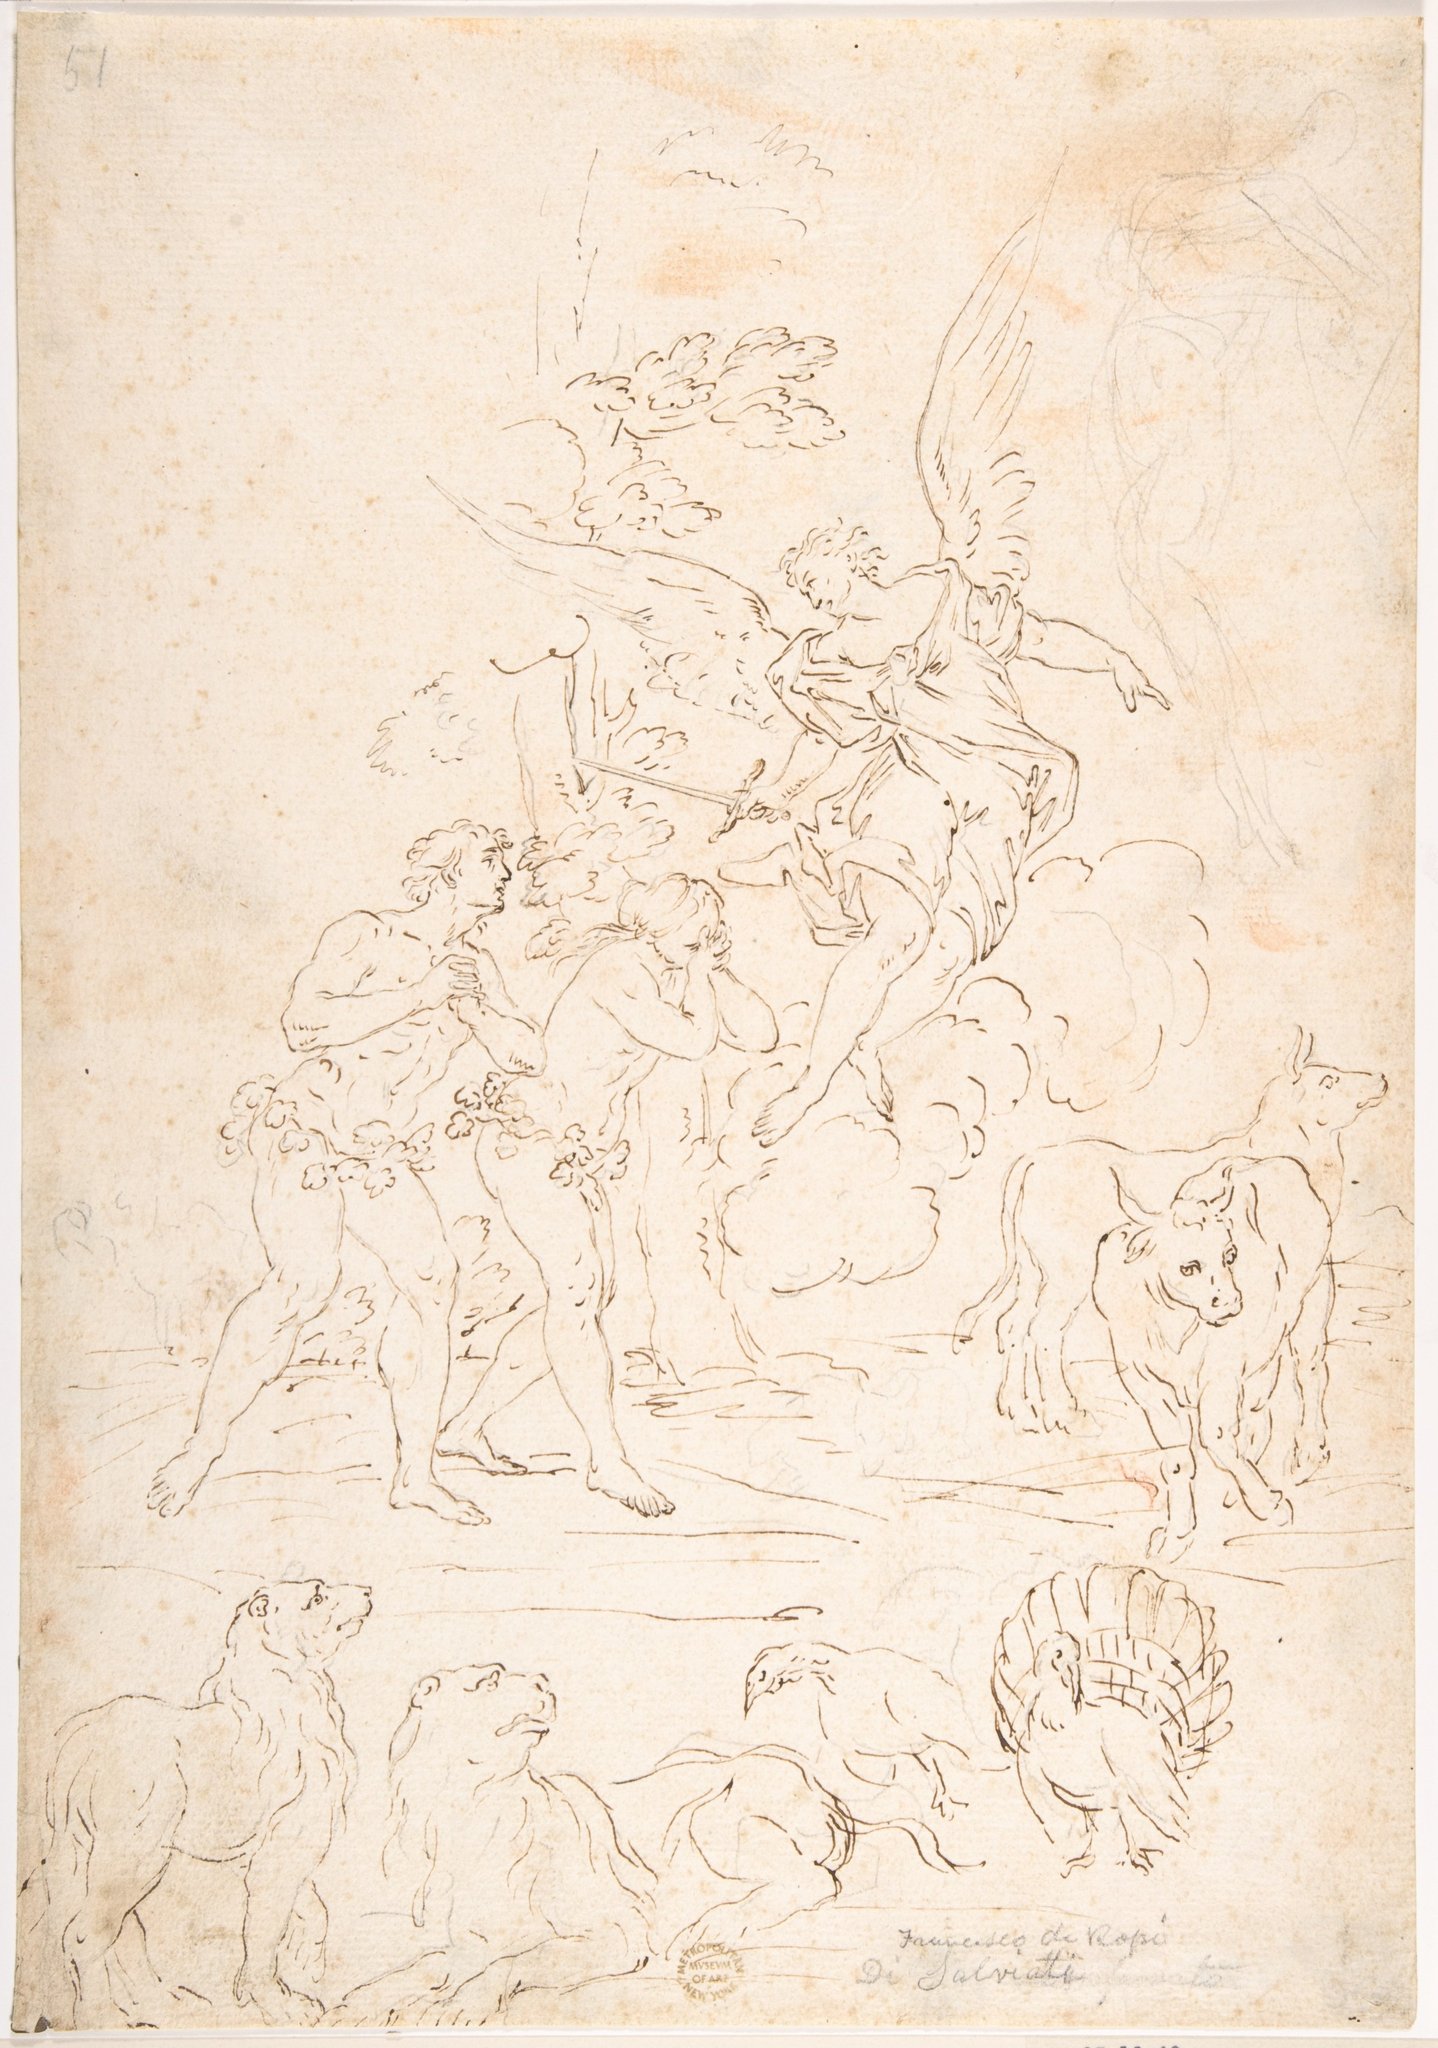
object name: drawing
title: The Expulsion from the Garden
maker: anonymous, italian, roman-bolognese, 17th century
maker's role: artist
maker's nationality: italian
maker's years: 1600-1700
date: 1601-1700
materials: chalk, ink, paper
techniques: pen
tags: birds,lions,angels,adam,eve